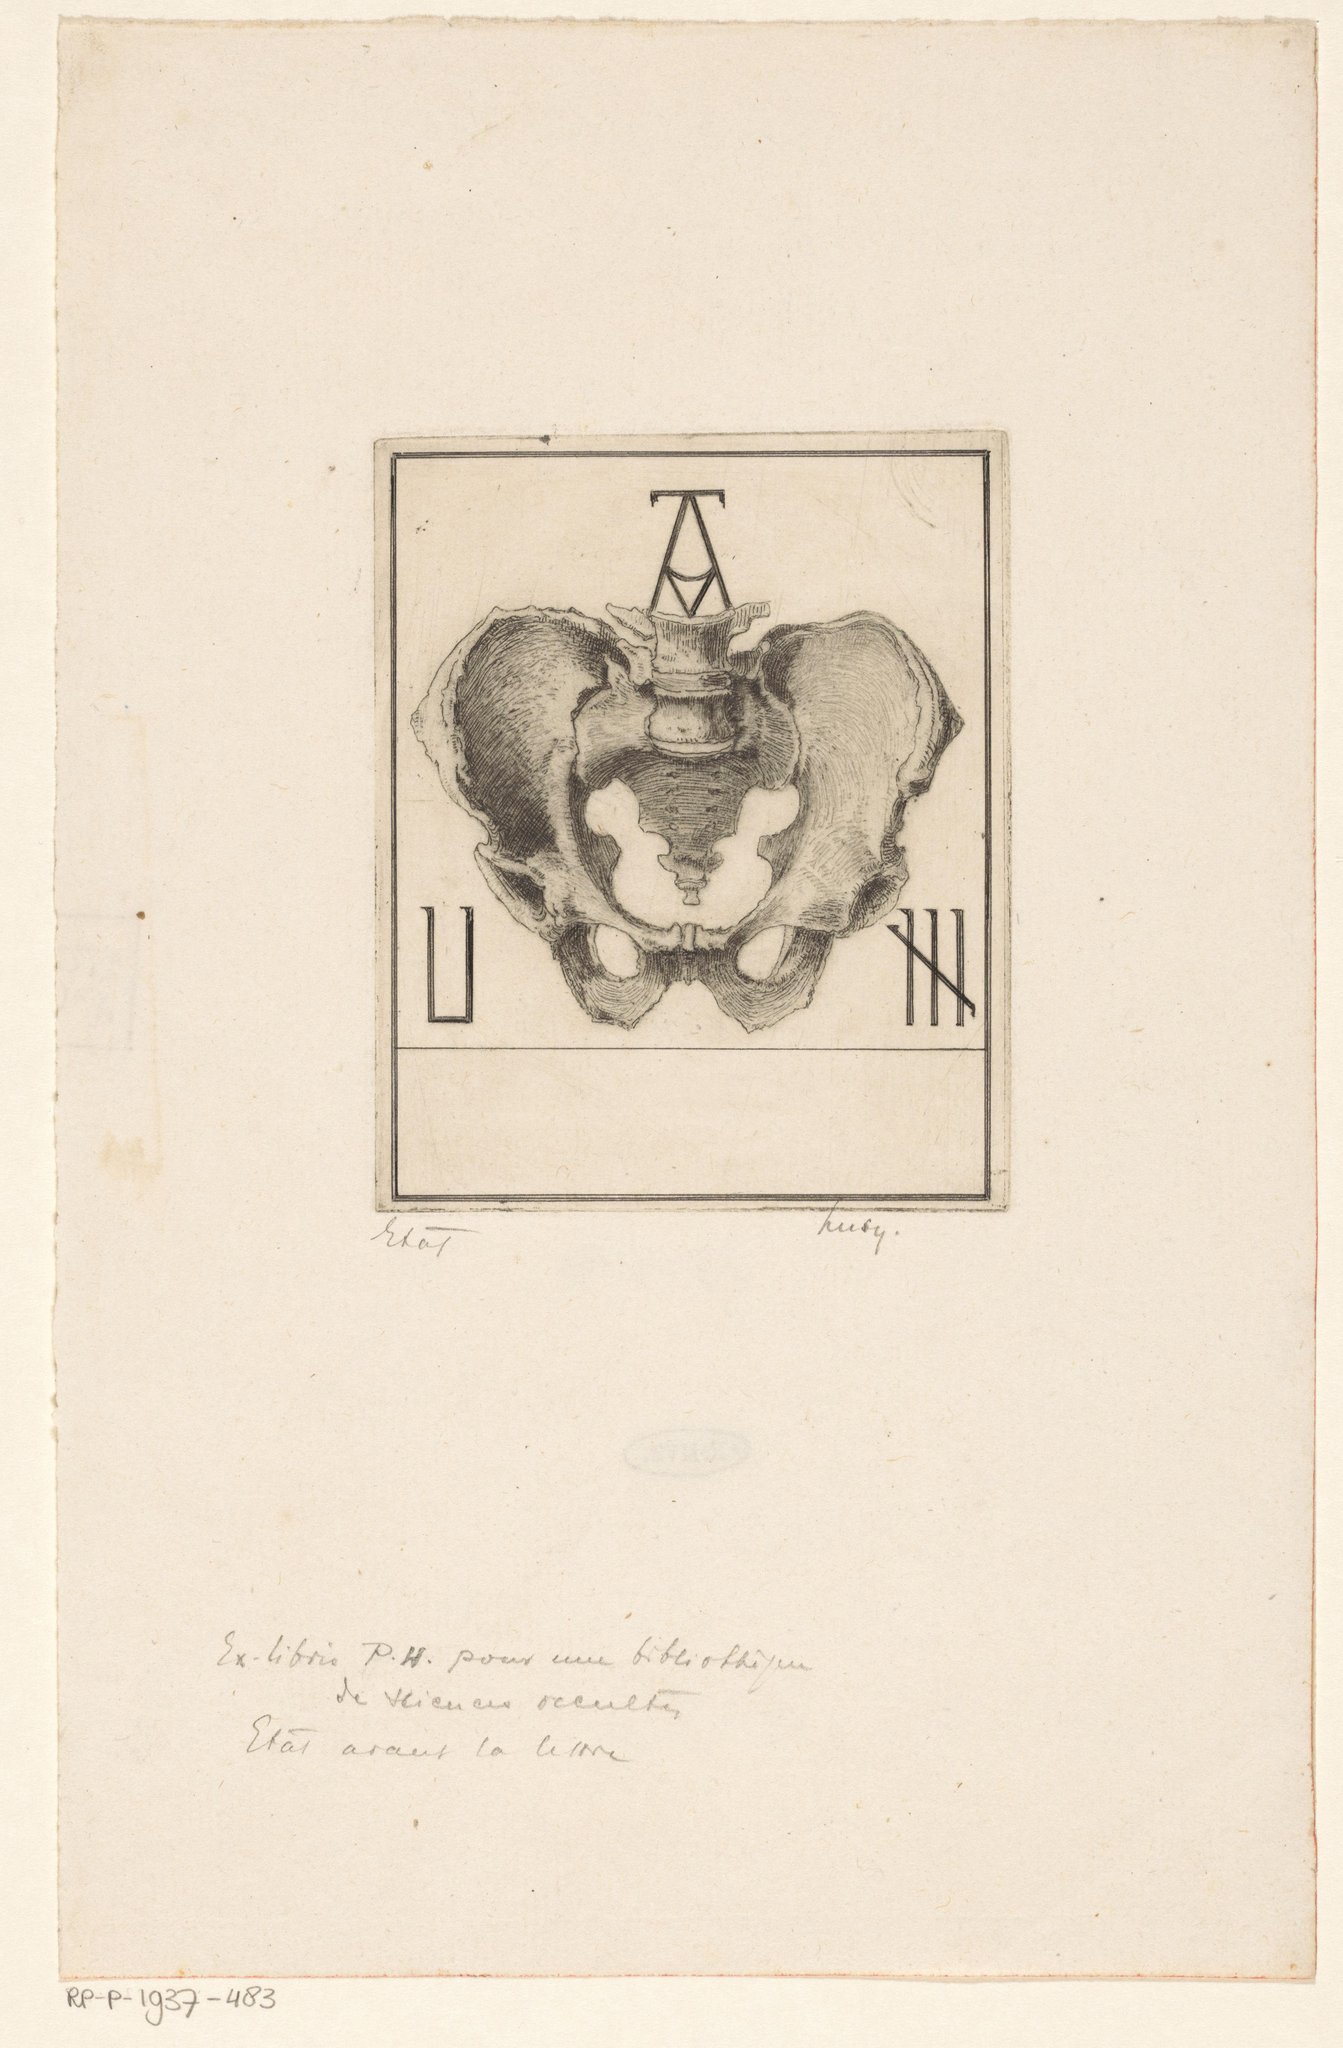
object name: print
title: Skelet van het bekken tussen letters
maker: marino m. lusy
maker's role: print maker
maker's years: 1880-1954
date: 1890-1937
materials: paper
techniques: drypoint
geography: italy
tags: pelvis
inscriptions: inscription: ‘Ex-Libris P.H. pour une bibliotheque ...’, collector's mark: Lugt 2228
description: Voorstelling van het skelet van het bekken tussen drie letters.